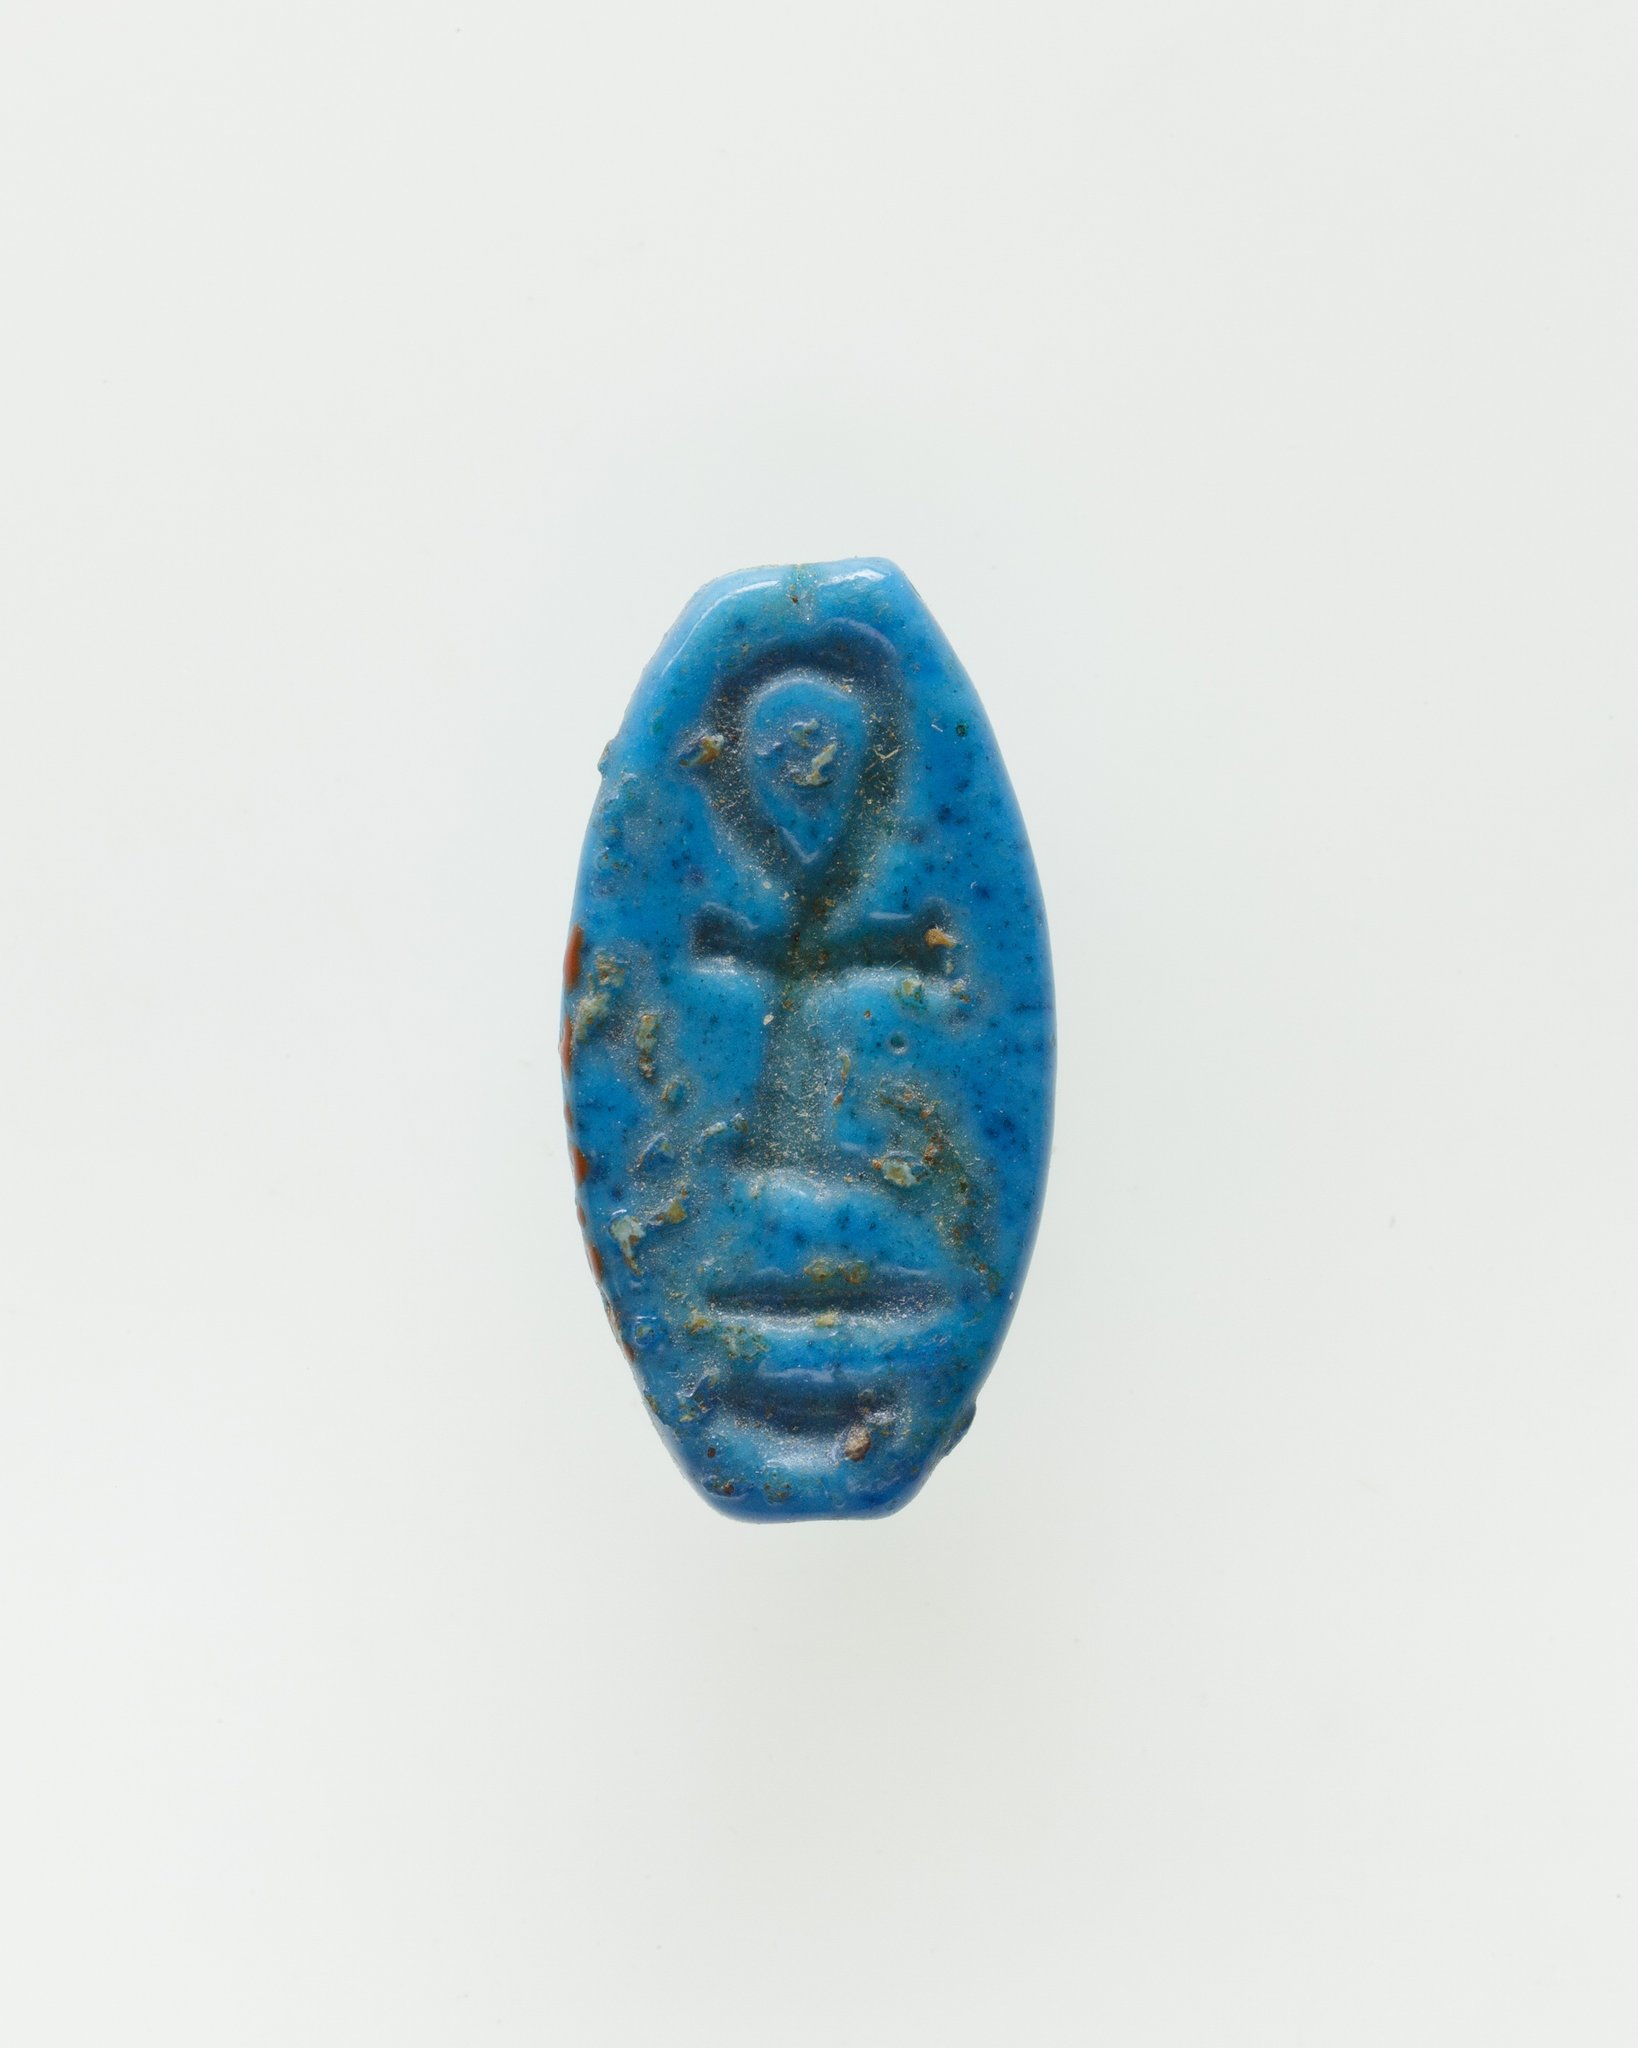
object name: cowroid, ankh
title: Cowroid Inscribed with an Ankh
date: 1492-1473 BCE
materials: faience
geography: egypt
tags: hieroglyphs,ankh